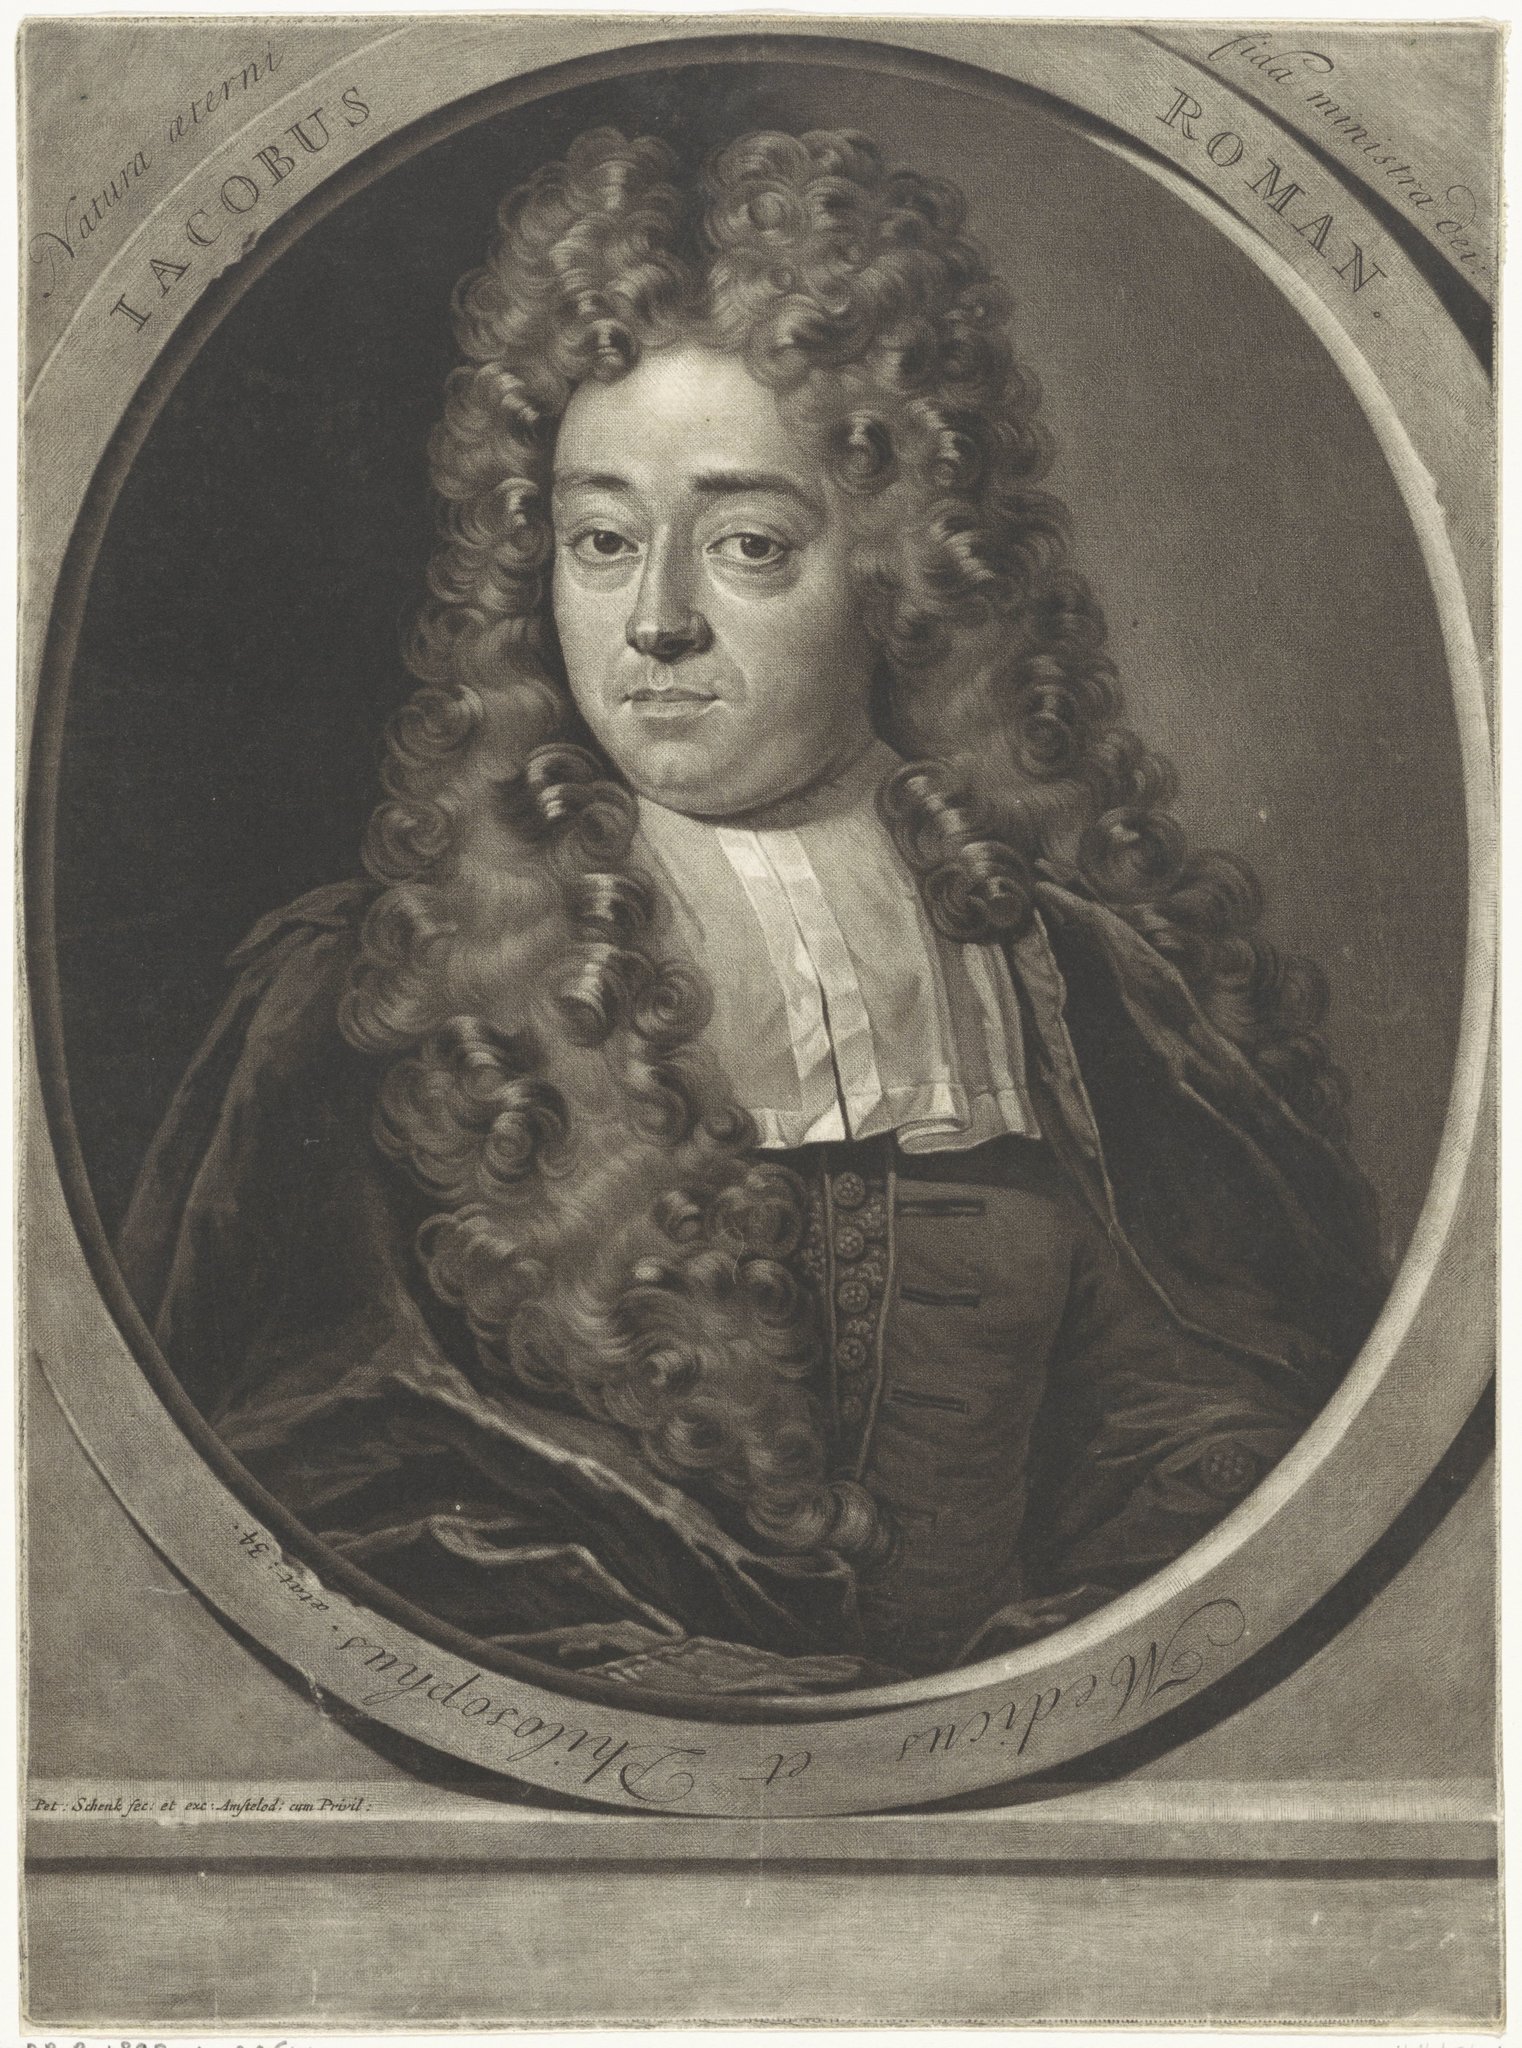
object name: print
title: Portret van Jacob Roman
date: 1670-1713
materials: paper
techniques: engraving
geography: amsterdam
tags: wig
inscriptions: collector's mark: Lugt 964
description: De arts Jacob Roman. Hij draagt een lange krulpruik.